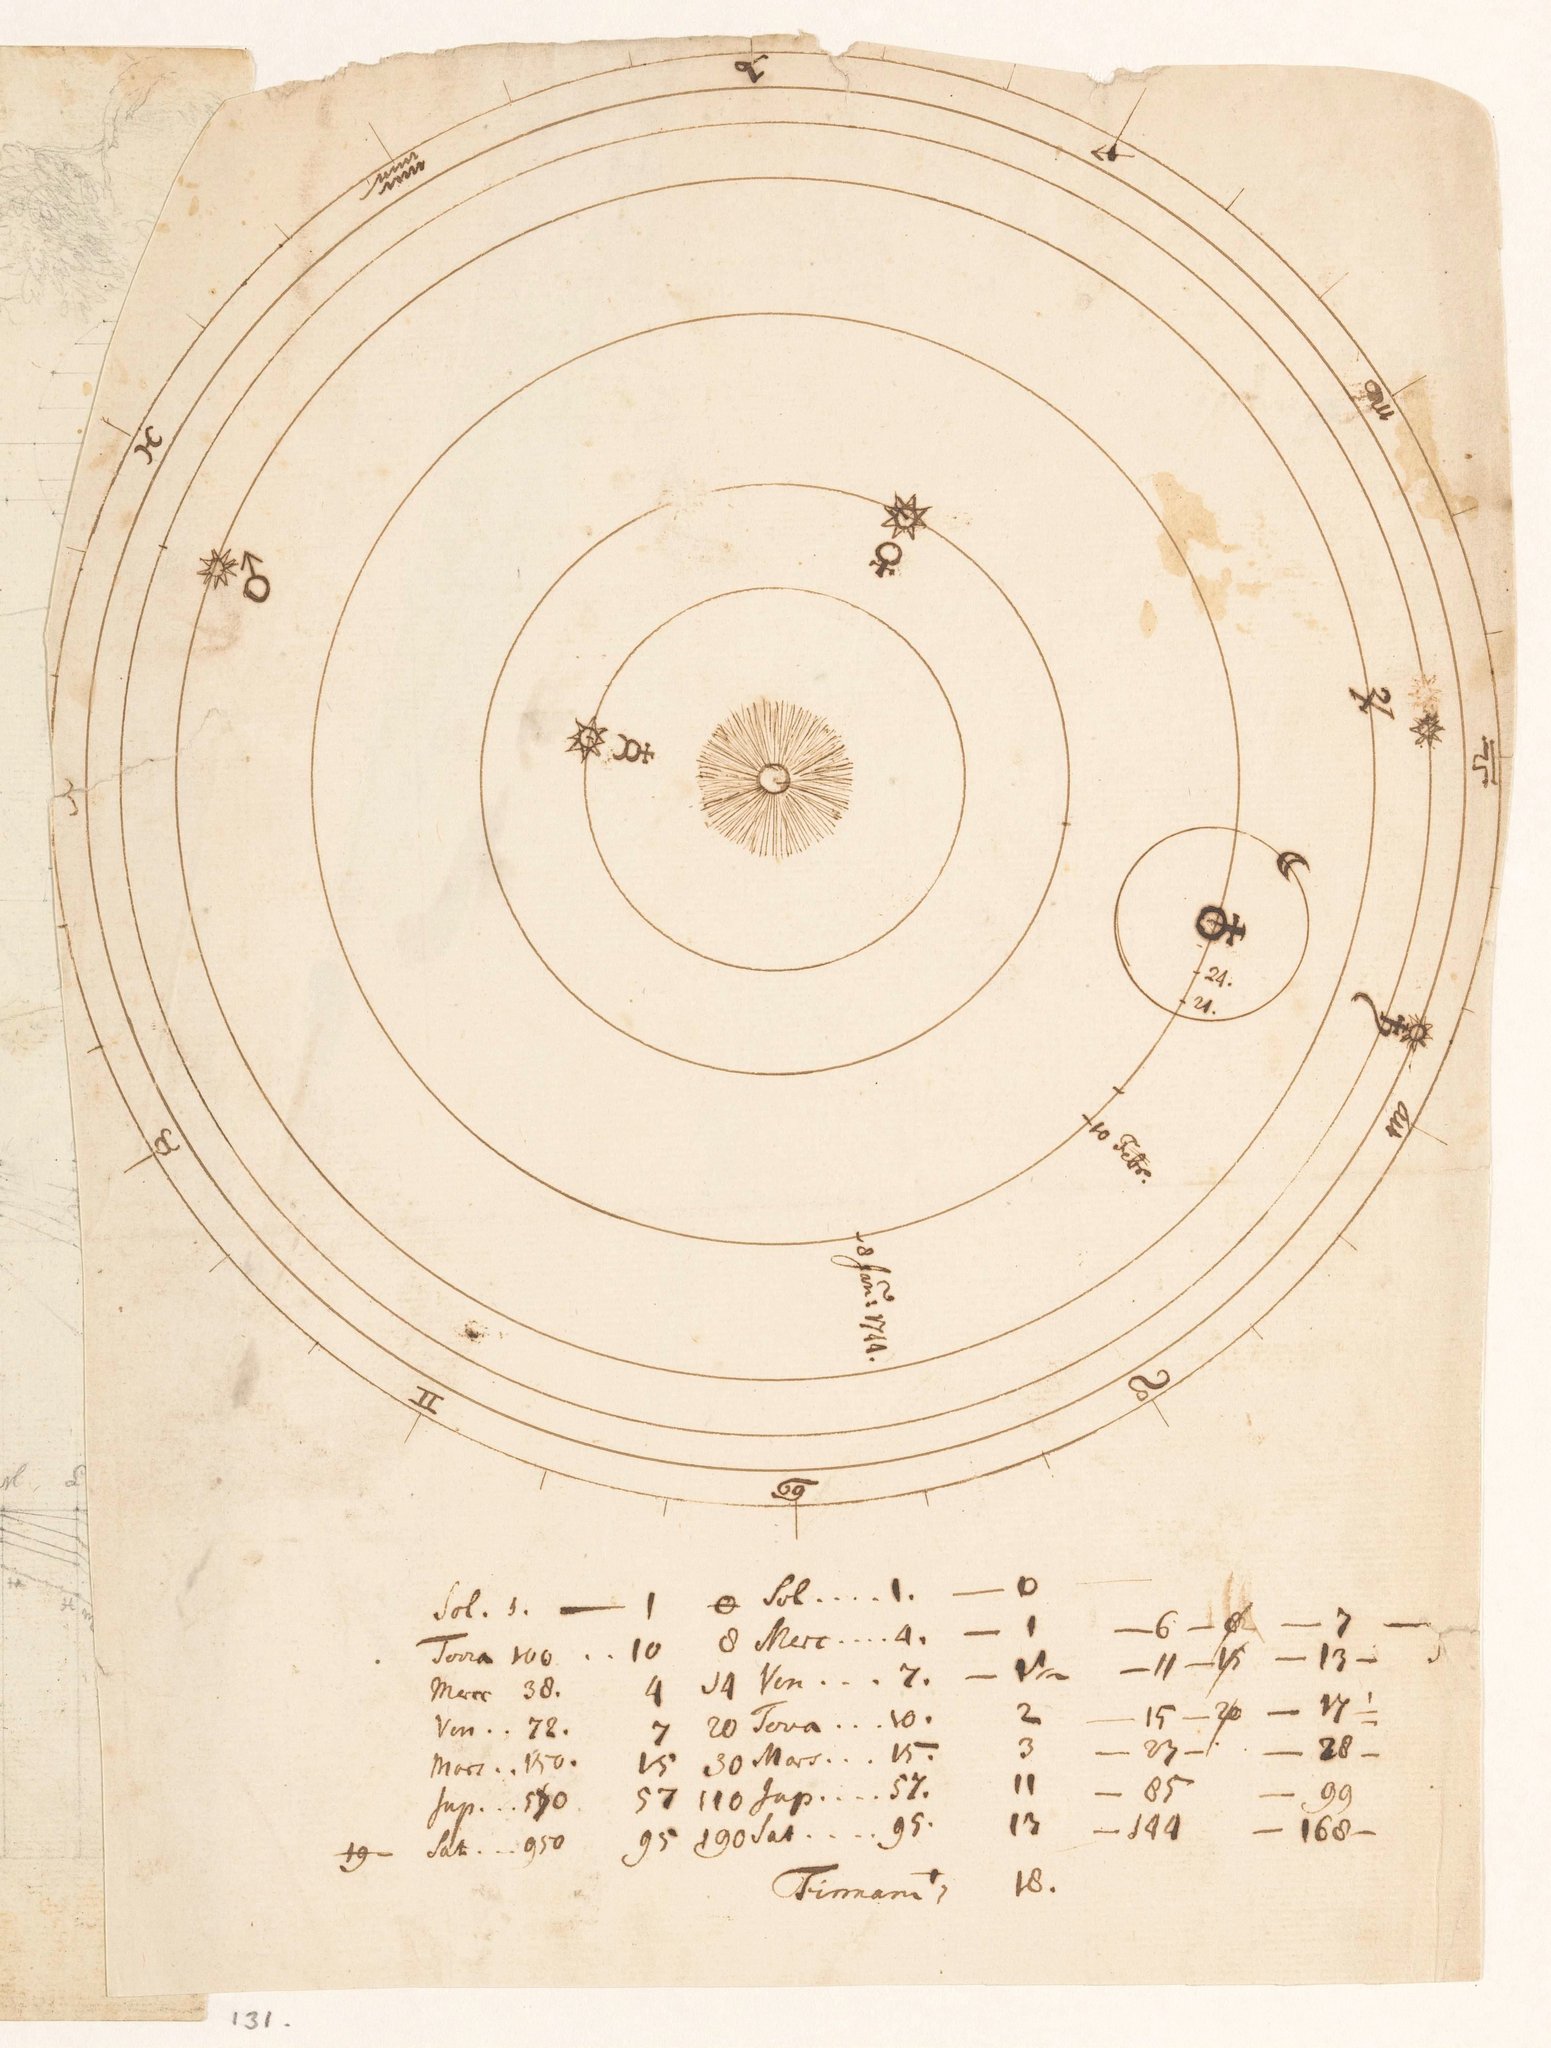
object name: drawing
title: Zonnestelsel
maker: jan brandes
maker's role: draughtsman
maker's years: 1743-1808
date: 1702-1792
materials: ink, paper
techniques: pen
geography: skälsebo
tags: planets; planetary system, solar system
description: Diagram van het zonnestelsel, met opschriften en legenda.